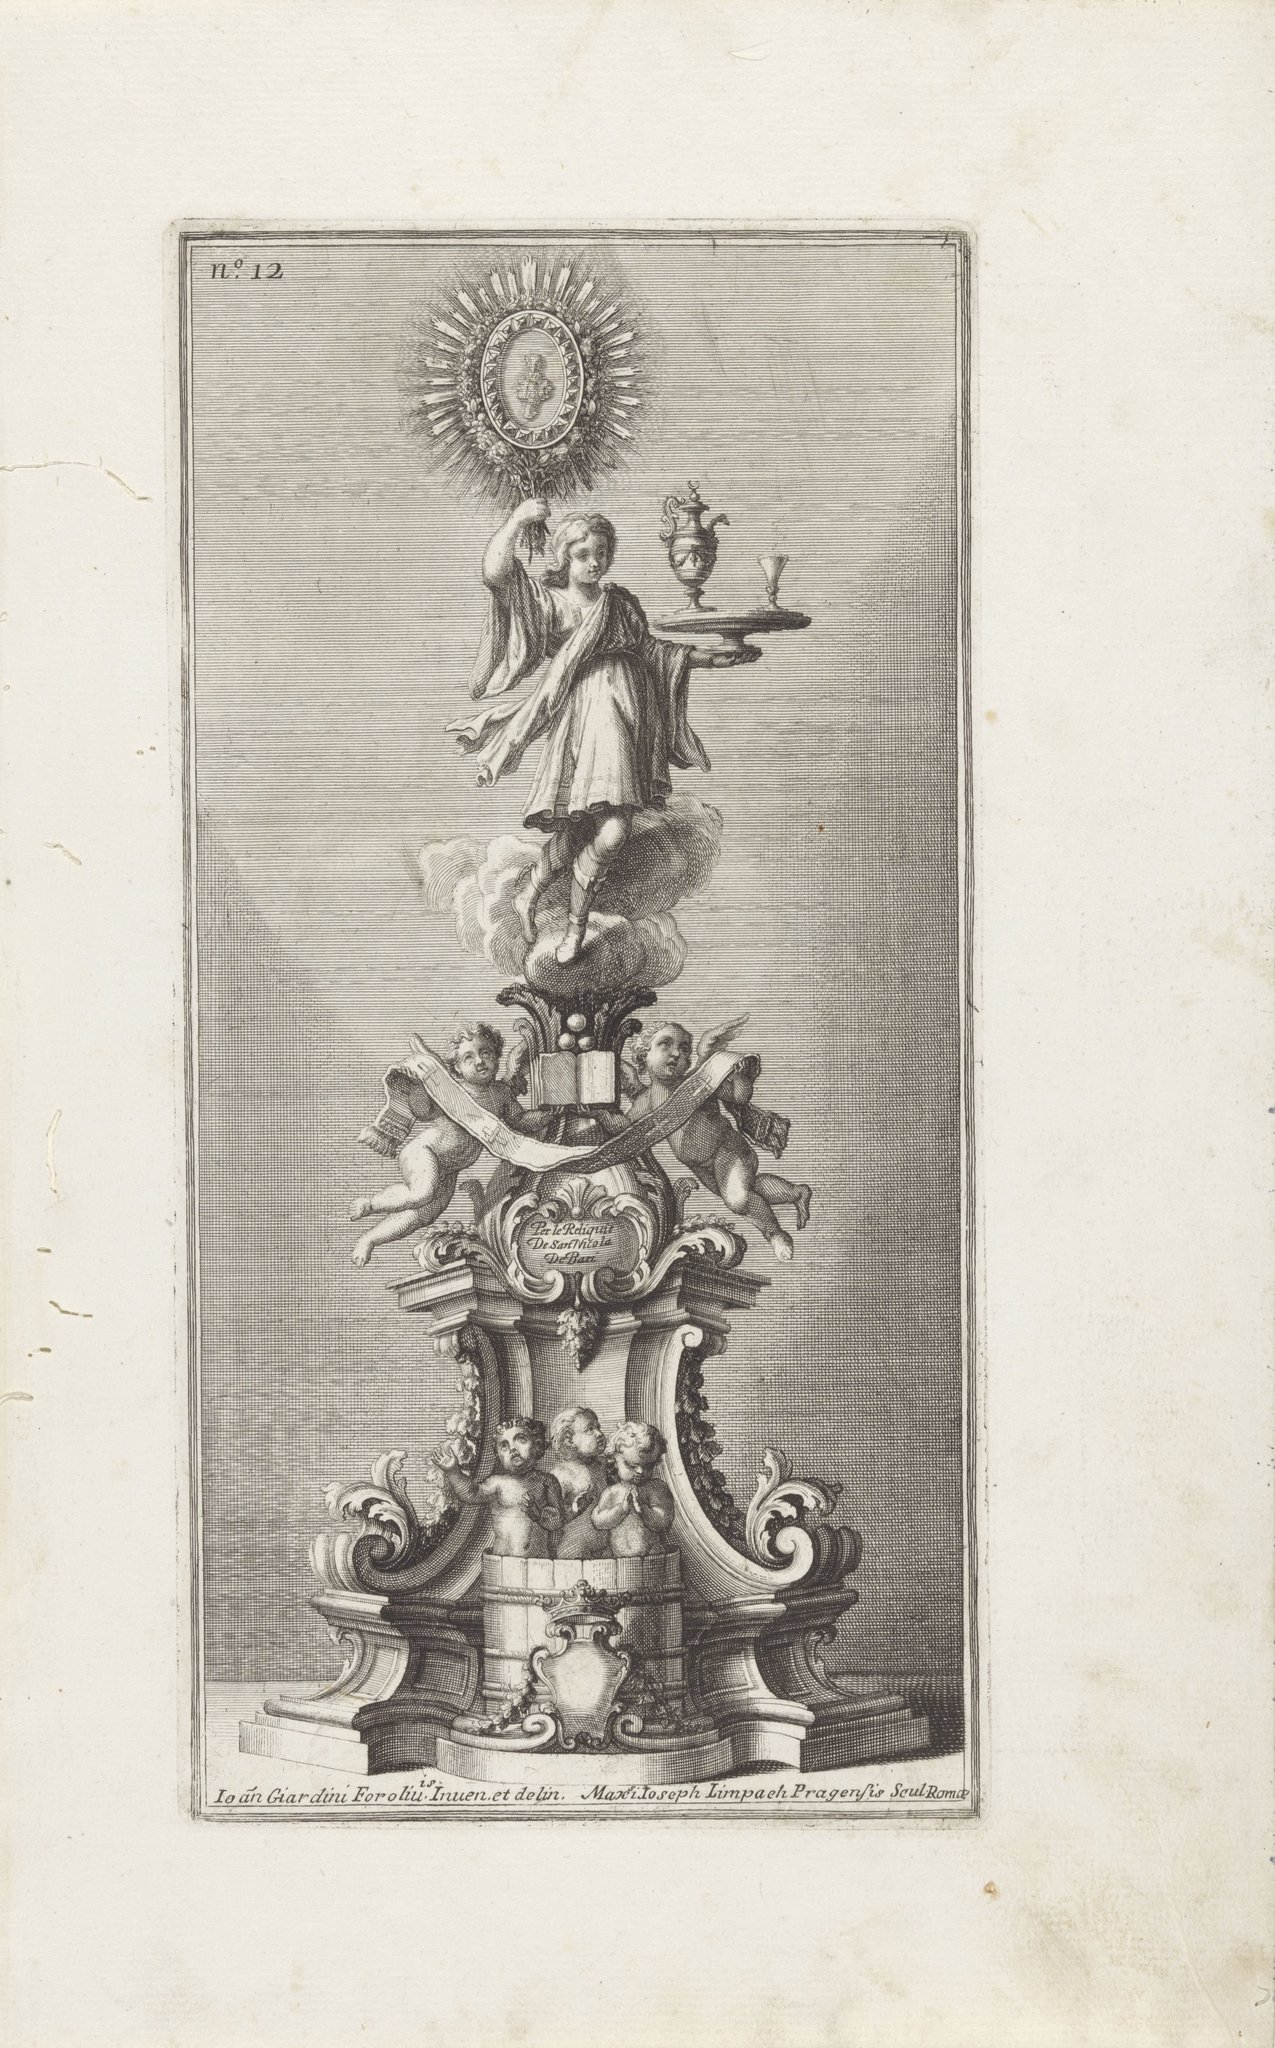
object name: print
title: Diverse kerkelijke voorwerpen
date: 1714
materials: paper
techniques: etching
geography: rome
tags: relics (and reliquaries), cupids: 'amores', 'amoretti', 'putti'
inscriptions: collector's mark: Lugt 2228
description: Prent maakt deel uit van een reeks van 100 ornamentprenten naar ontwerp van Giovanni Giardini.